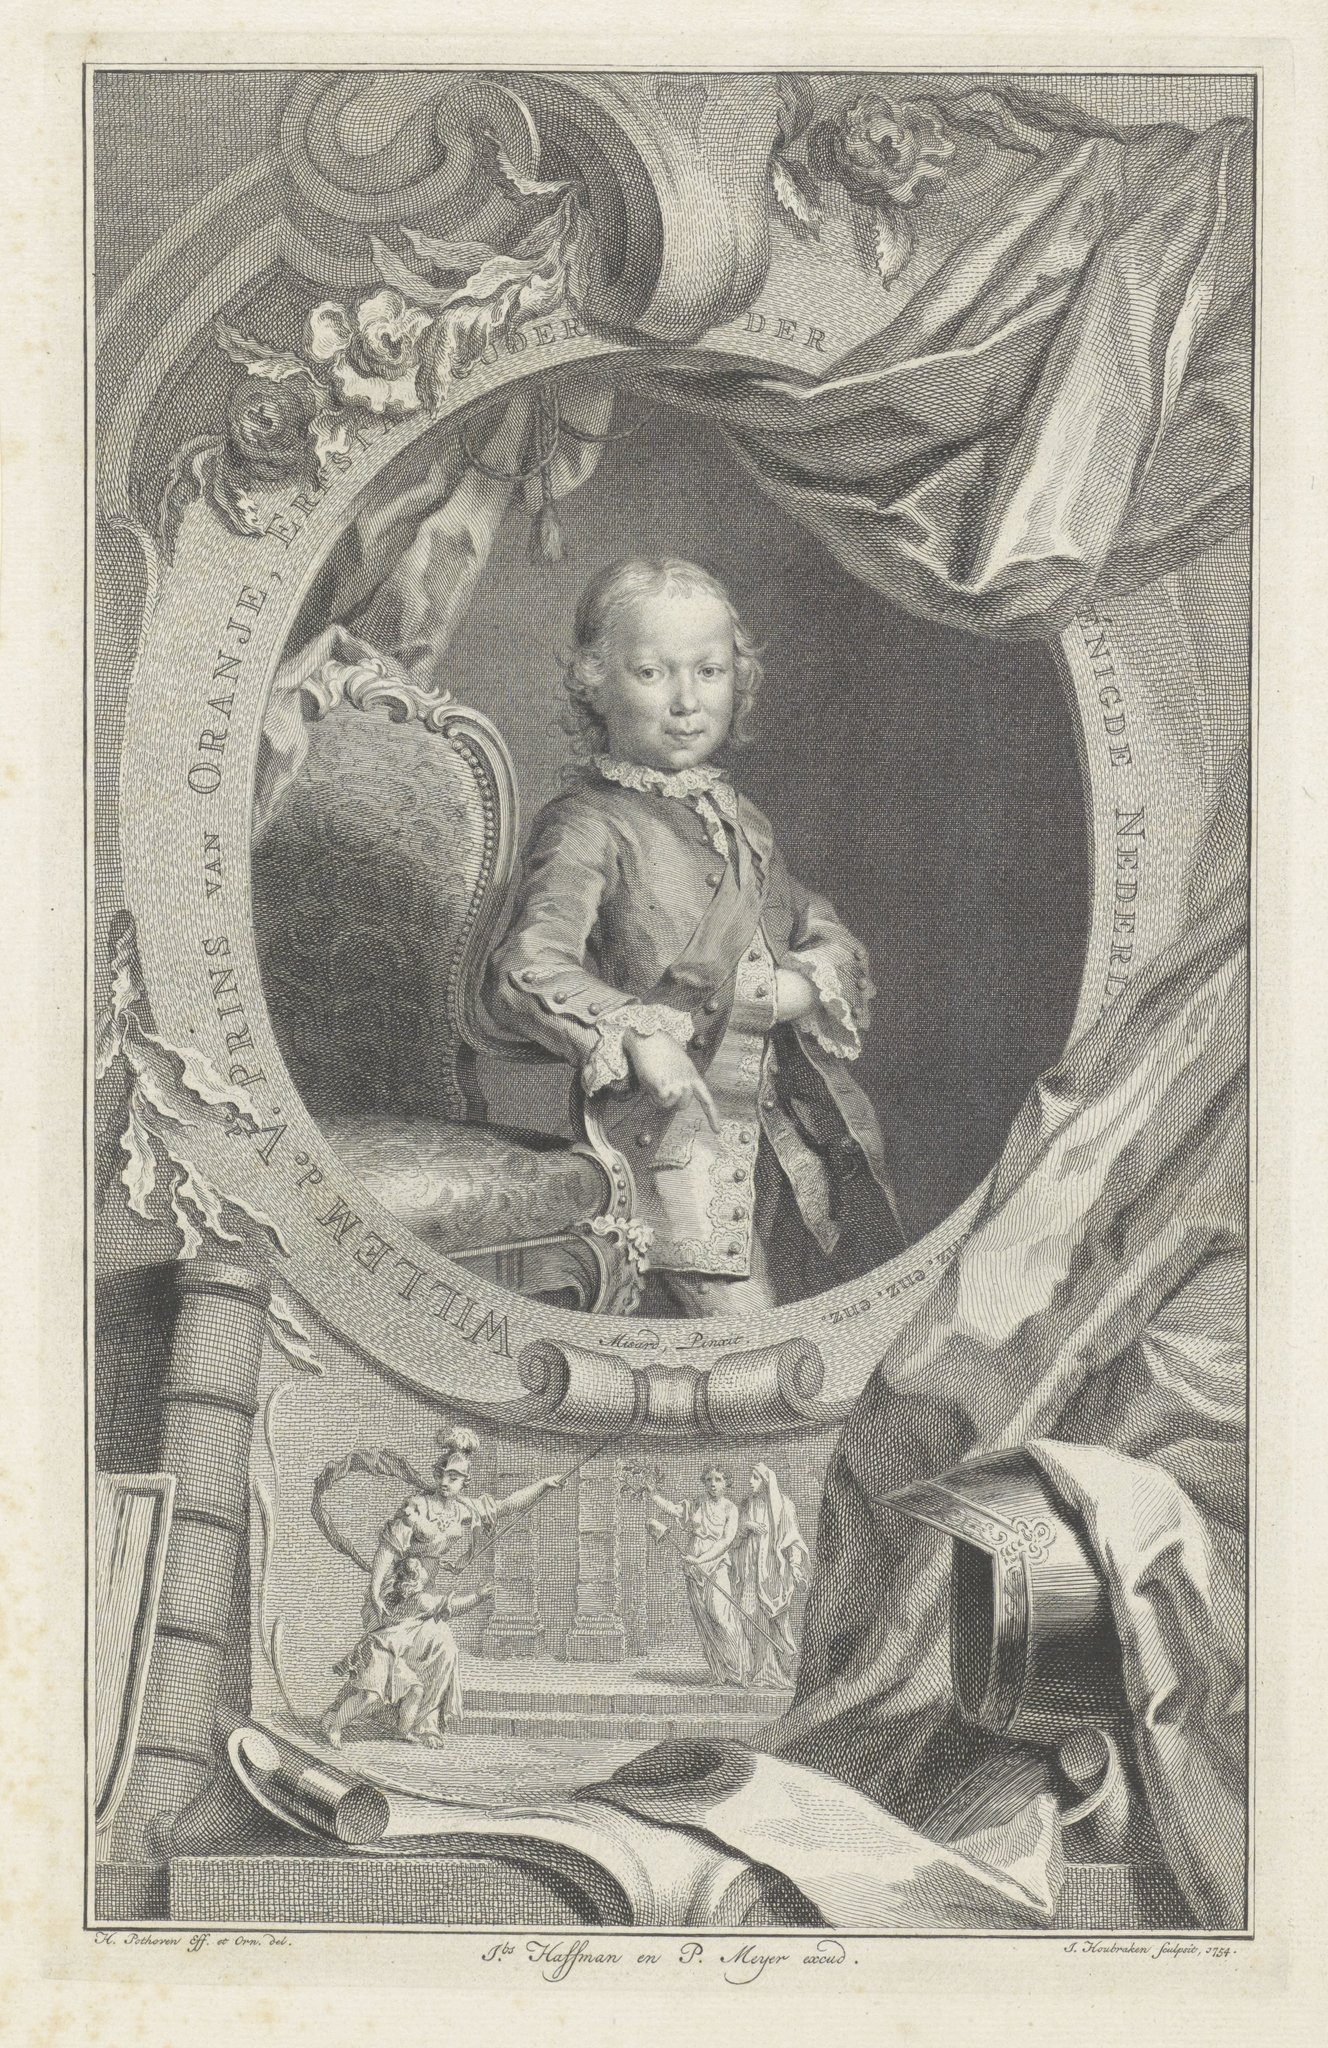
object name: print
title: Portret van Willem V, prins van Oranje-Nassau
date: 1754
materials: paper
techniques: engraving, etching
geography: amsterdam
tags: the hague, william v (prince of orange)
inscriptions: date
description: Portret van Willem V in een ovaal met randschrift. Rondom ligt een aantal allegorische objecten, waaronder een helm en een boek. Op het reliëf een allegorische voorstelling.